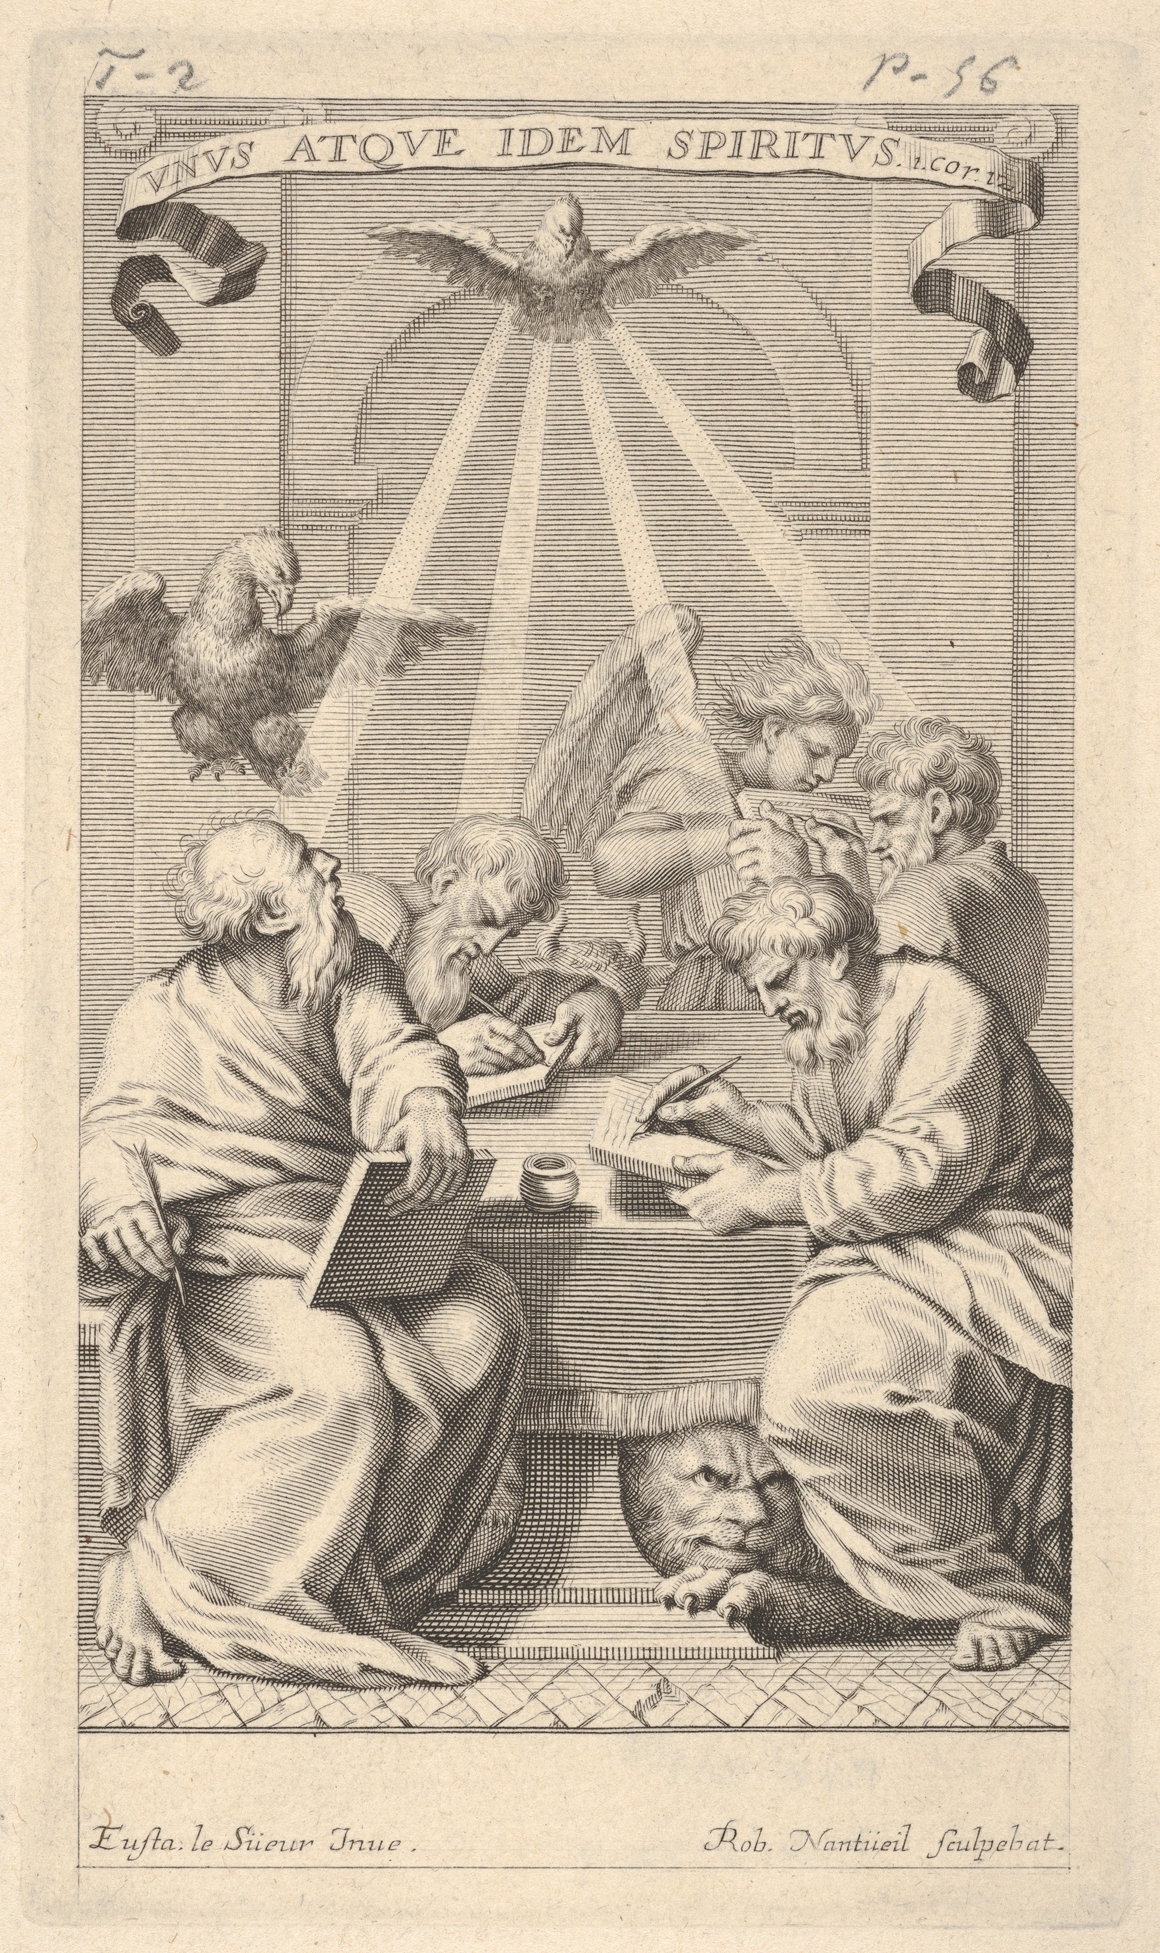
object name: print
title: The Four Evangelists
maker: robert nanteuil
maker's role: artist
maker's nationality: french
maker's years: 1623-1678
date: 1653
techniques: engraving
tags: birds,men,lions,angels,writing